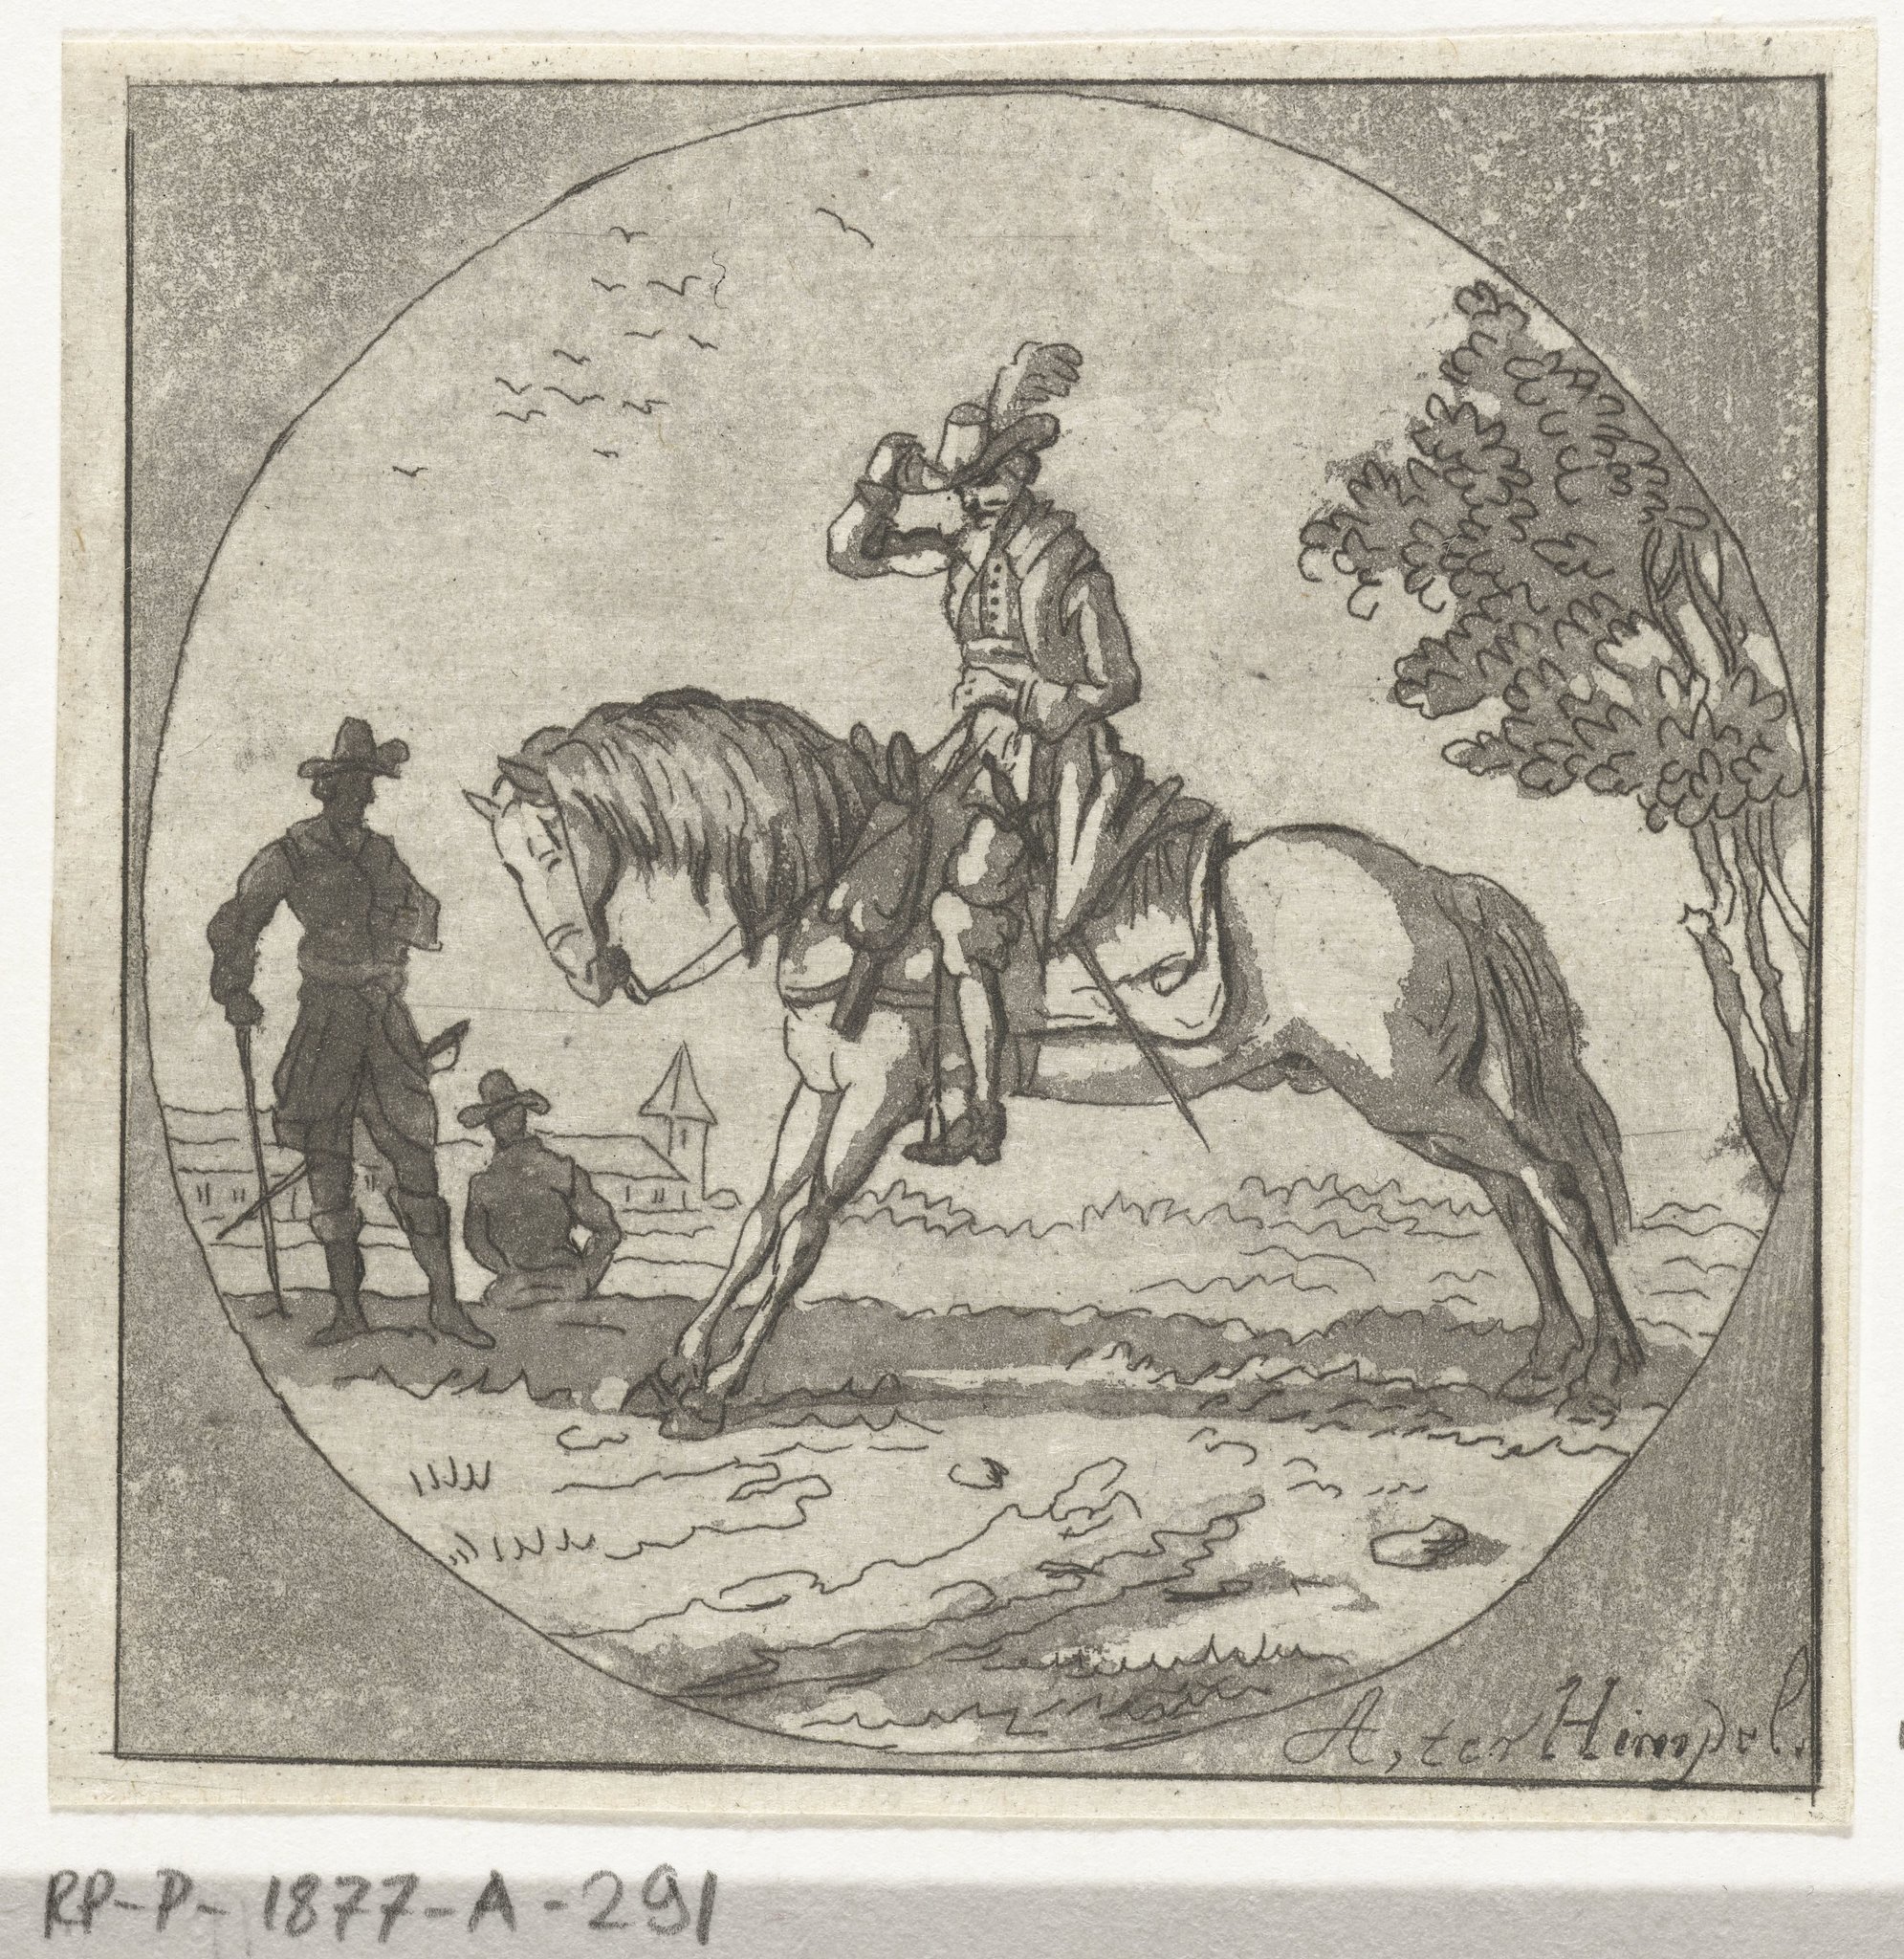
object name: print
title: Ruiter in medaillon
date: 1778-1838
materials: paper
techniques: aquatint, etching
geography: netherlands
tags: riding a horse, ass, or mule; rider, horseman, baring the head, lifting one's hat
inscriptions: collector's mark: Lugt 2228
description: Een ruiter te paard groet twee mannen die langs de weg staan.